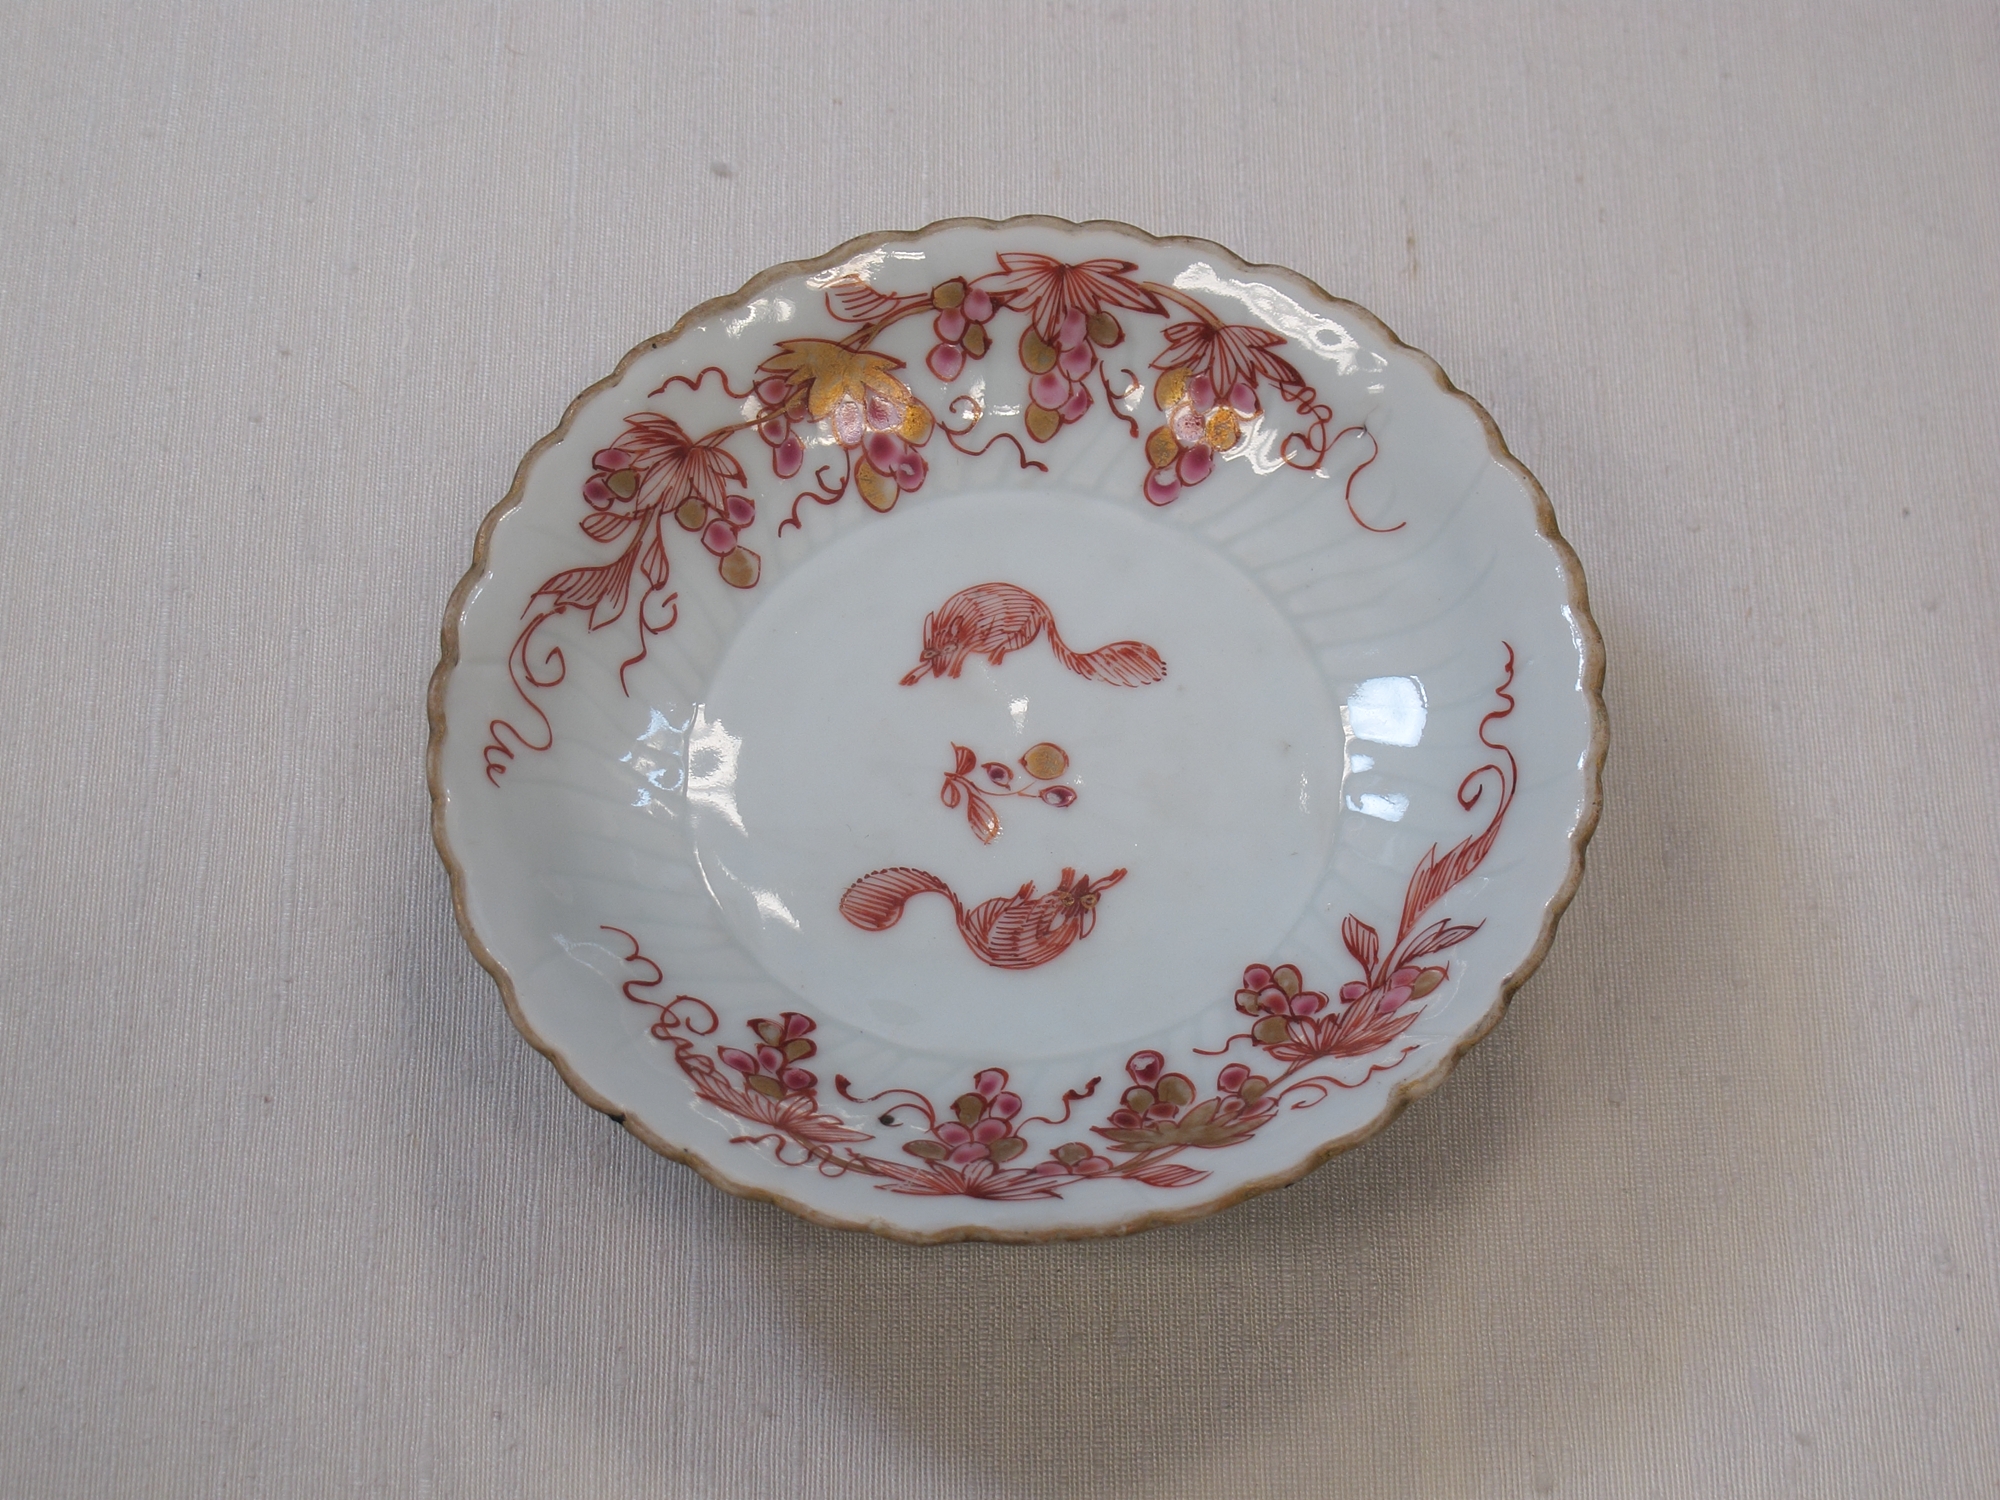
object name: saucer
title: Saucer with squirrels and grape vines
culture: chinese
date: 1767-1800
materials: enamel, porcelain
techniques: overglaze, painting, polychrome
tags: squirrels